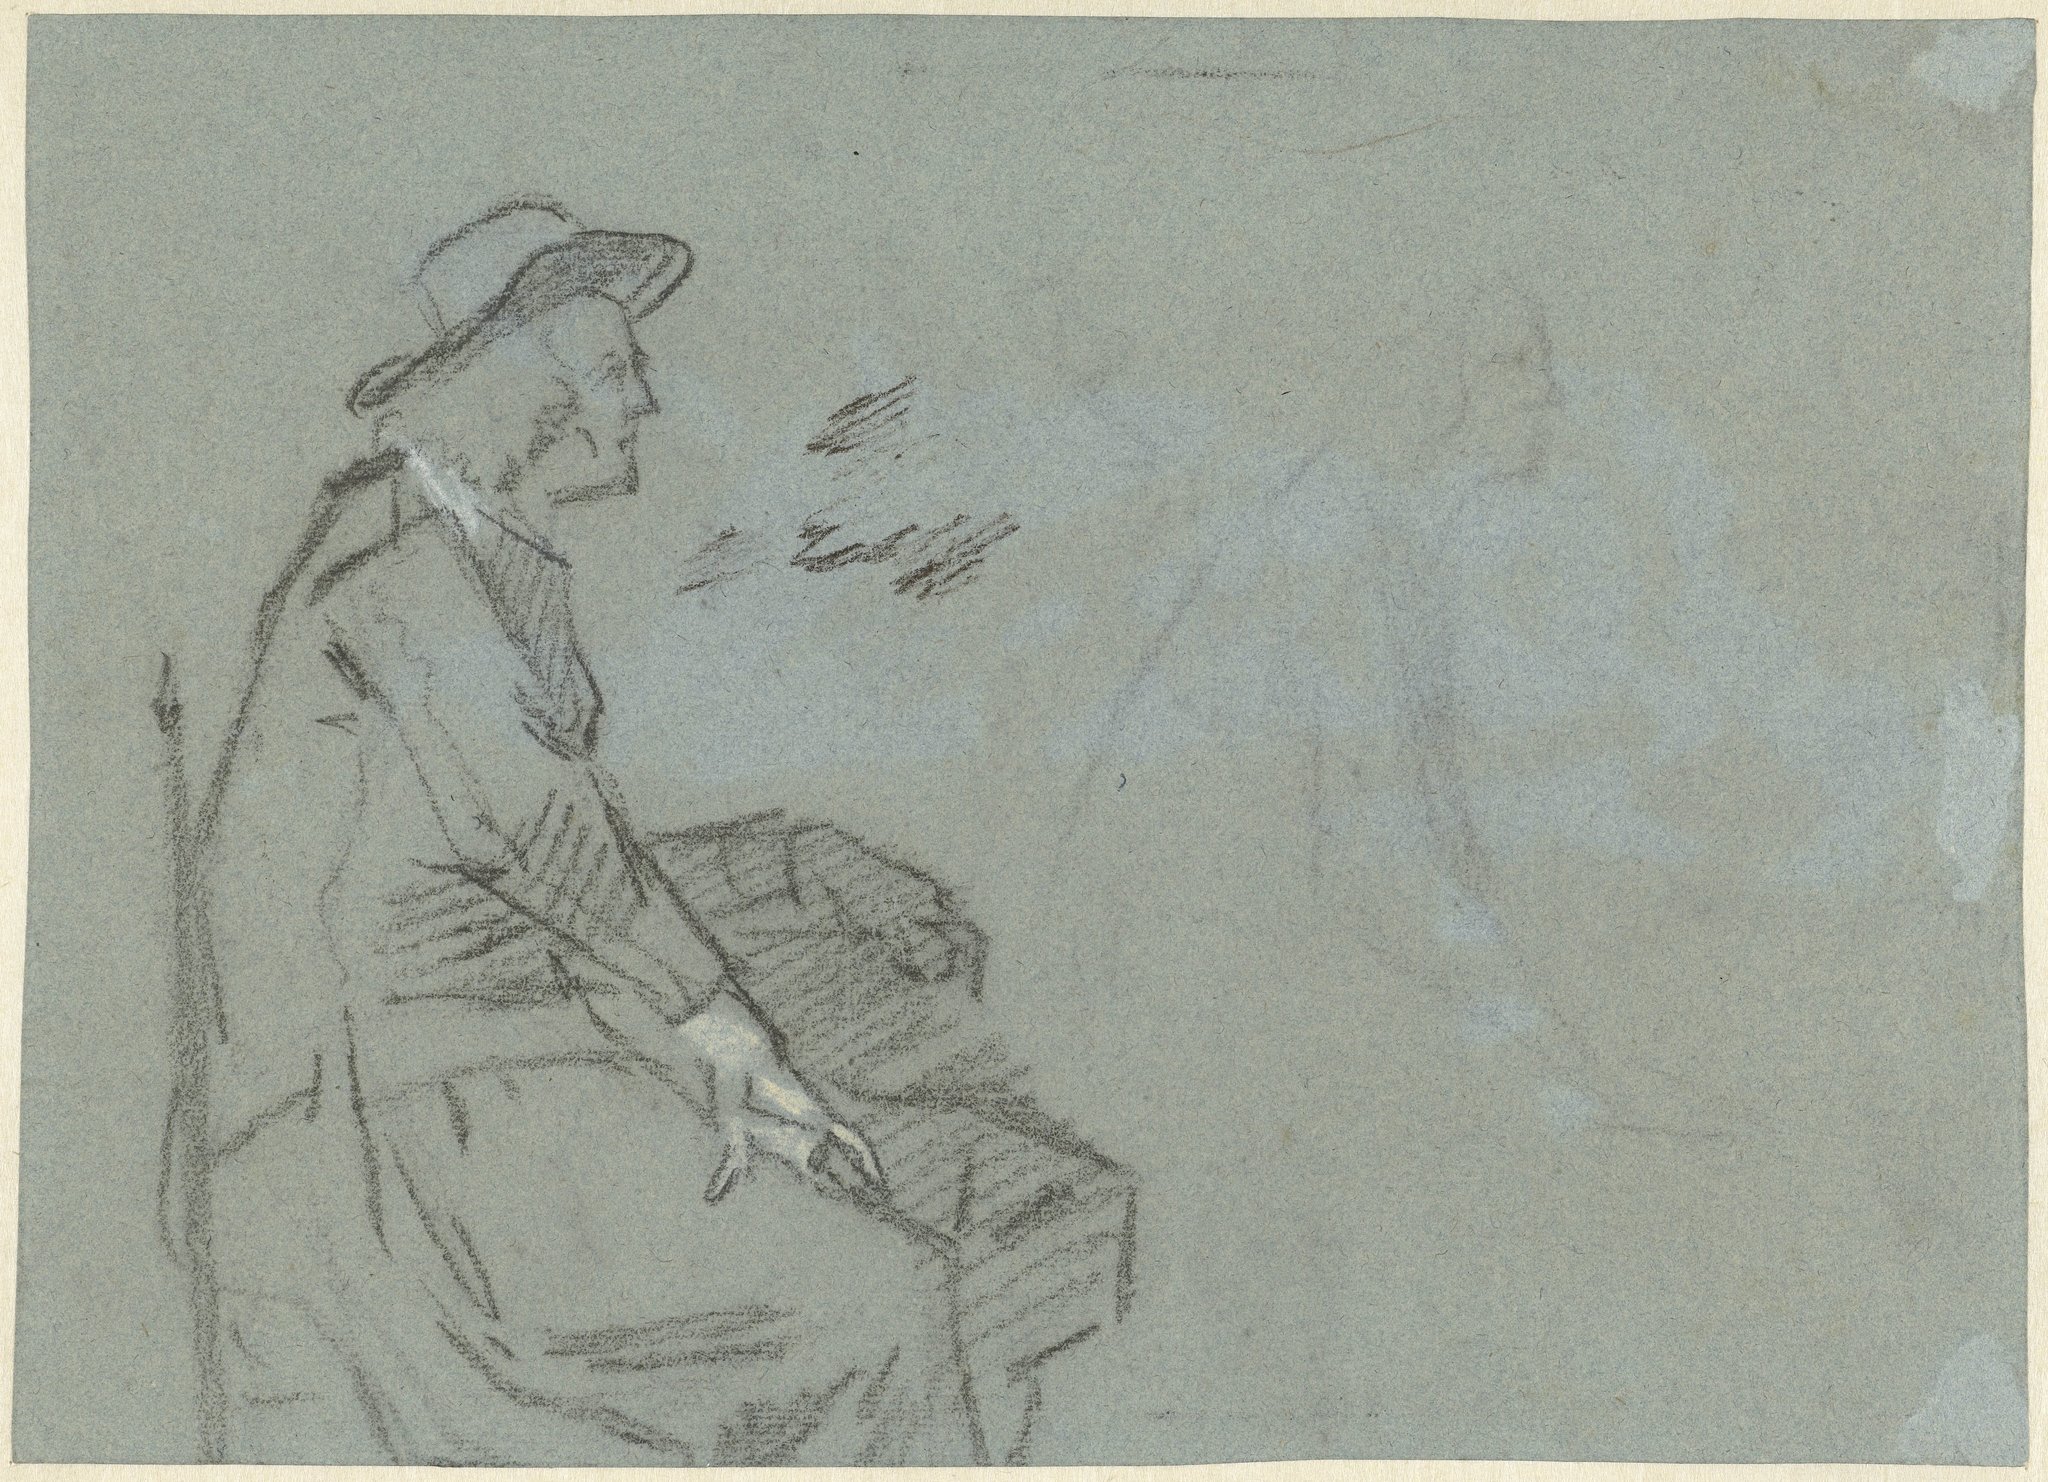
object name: drawing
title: Twee studies van een zittende man, in profiel naar rechts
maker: cornelis troost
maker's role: draughtsman, painter, print maker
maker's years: 1696-1750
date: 1738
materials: chalk, paper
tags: (asselyn, jan claasz of de gewaande dienstmaagd) specific works of literature (with author, title)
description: Scène uit "Jan Claasz of de gewaande dienstmaagd" van Thomas Asselijn.